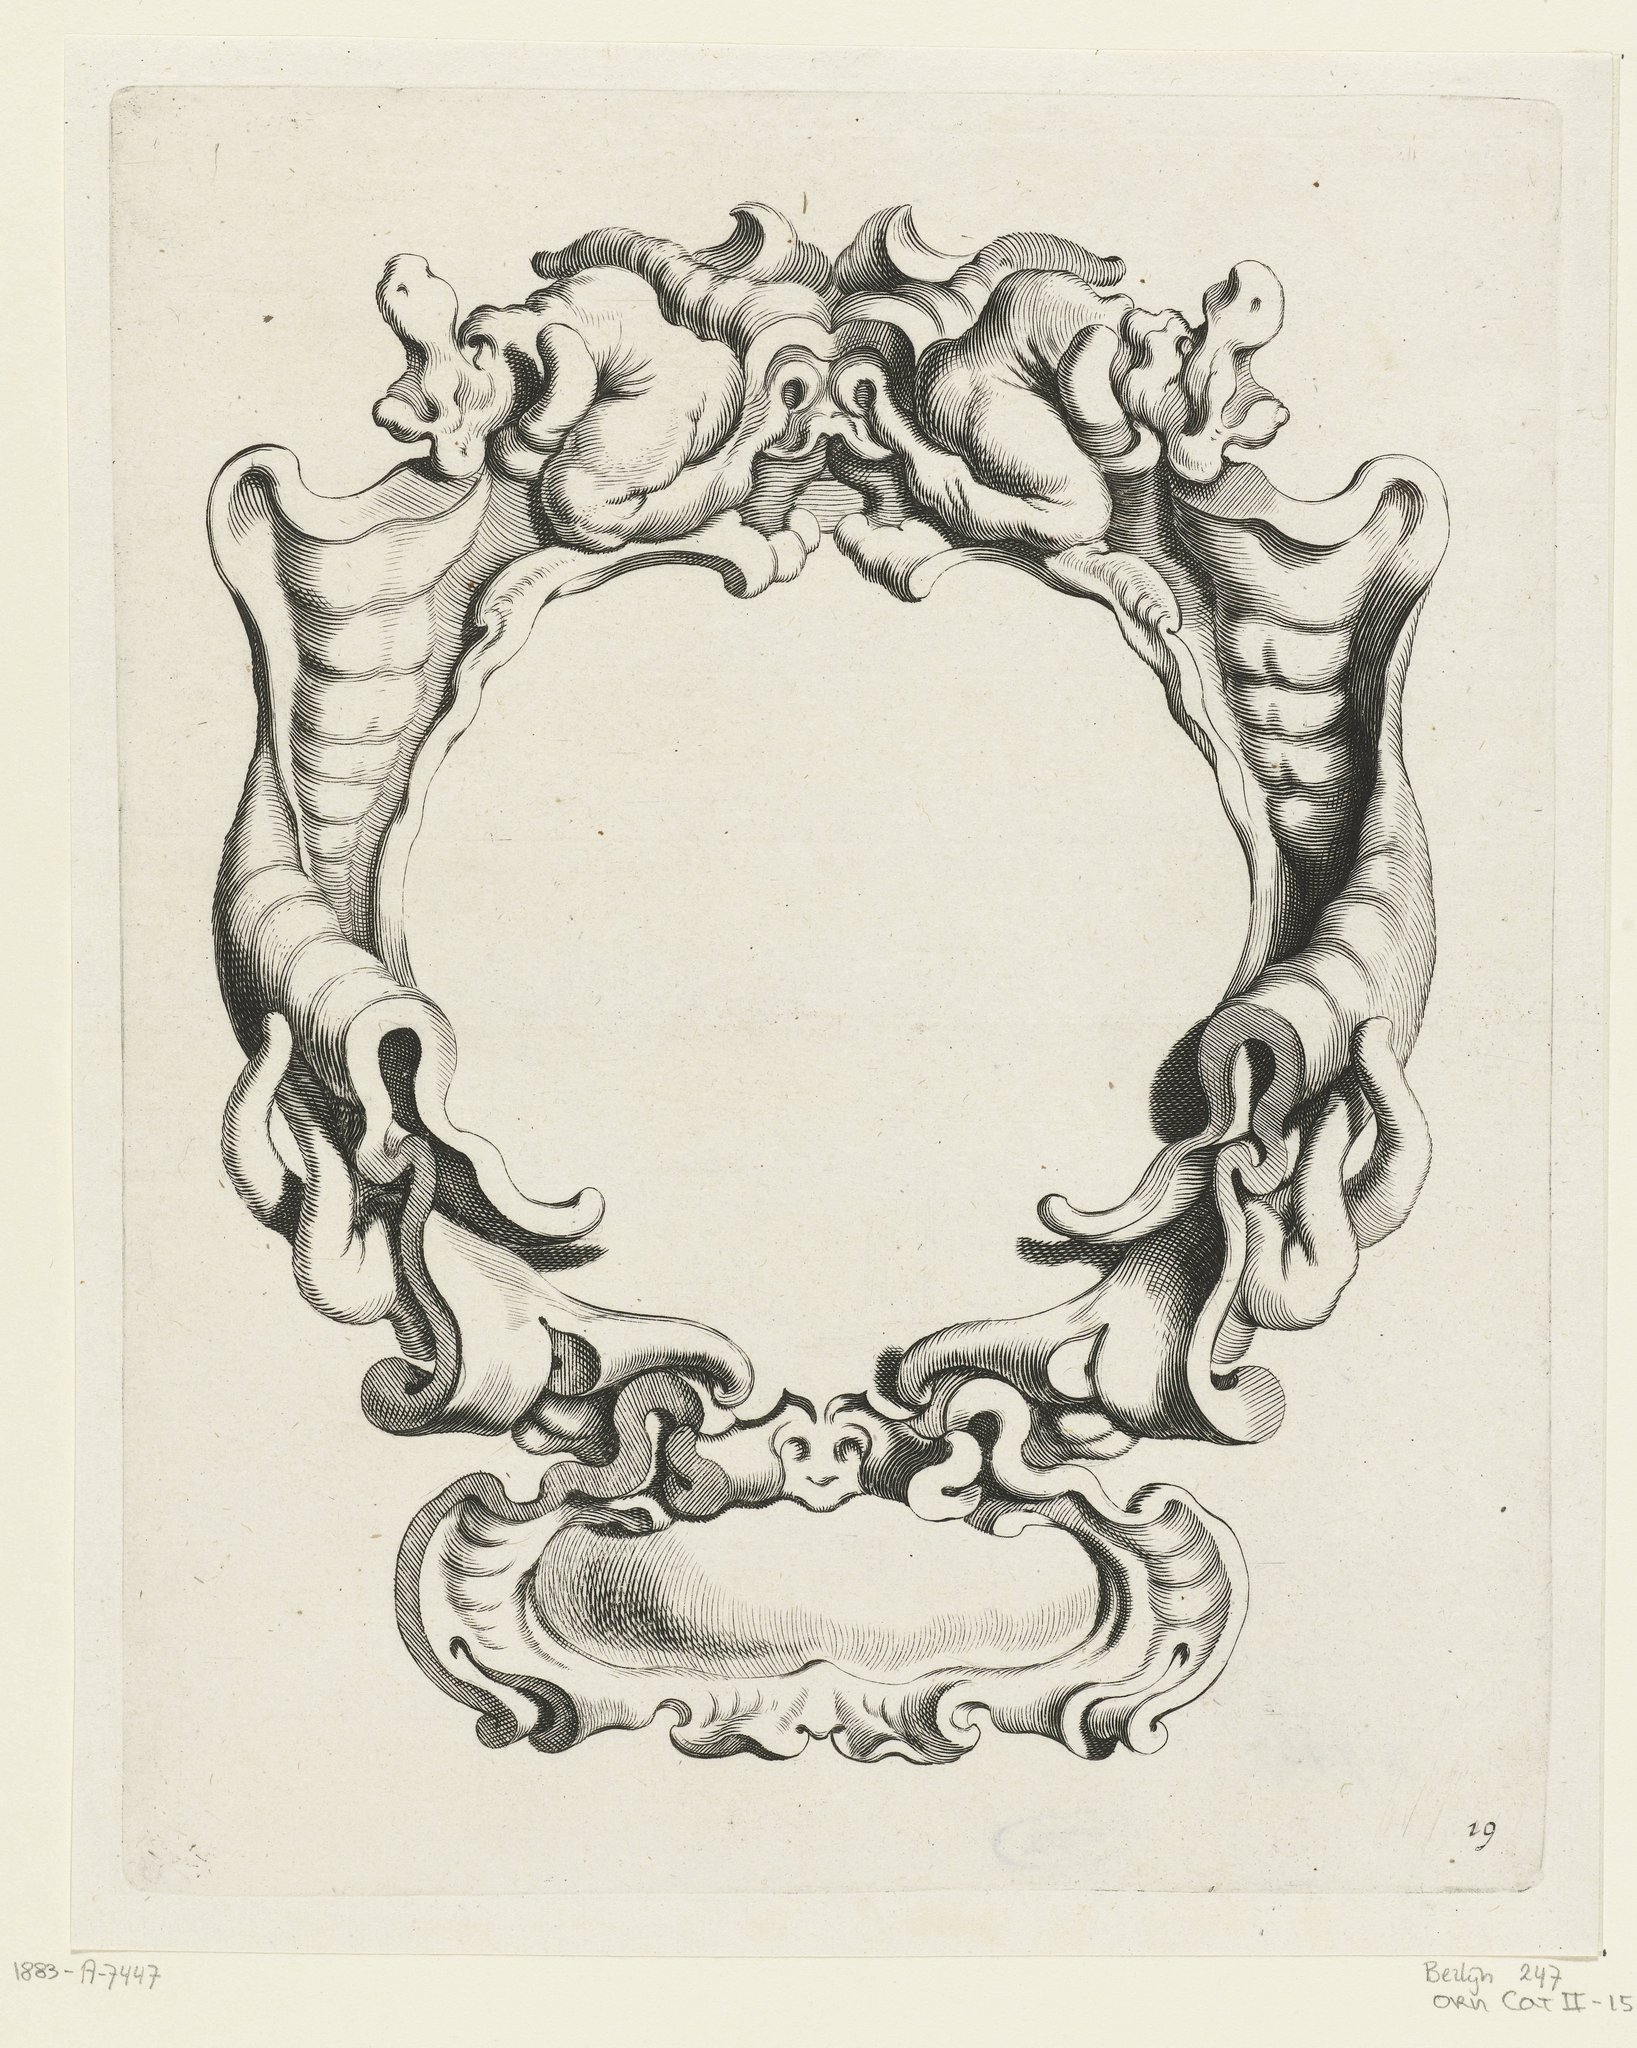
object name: print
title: Veelderhande Niewe Compartemente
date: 1640-1655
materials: paper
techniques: engraving, etching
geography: amsterdam